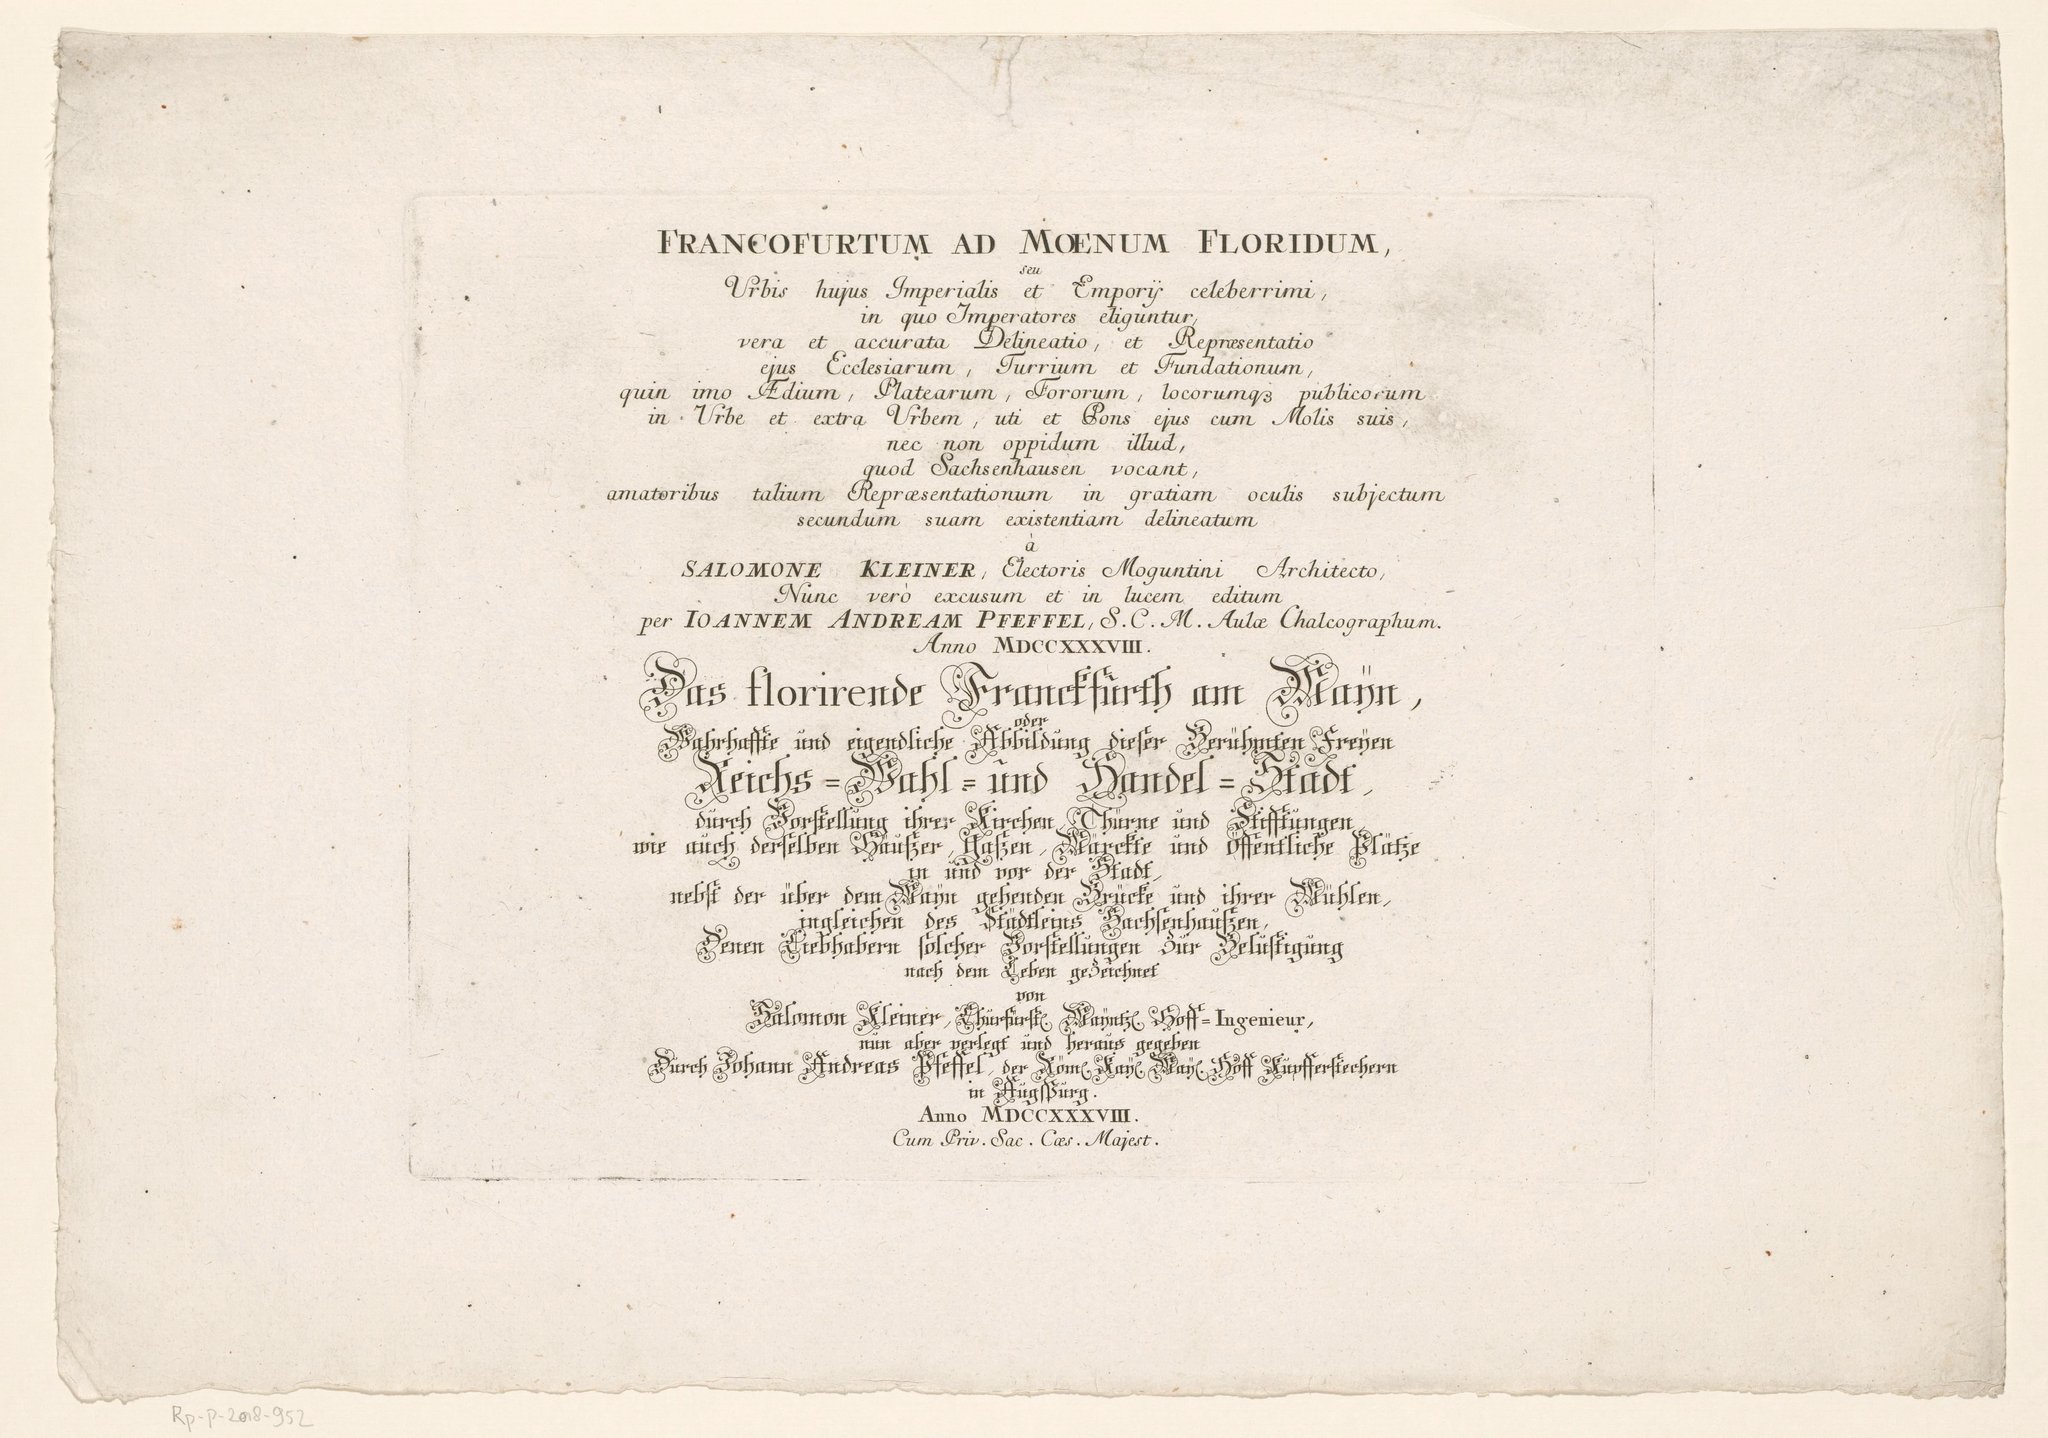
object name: titelblad, titelpagina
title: Francofurtum ad Moenum Floridum, urbis hujus imperialis (...)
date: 1738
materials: paper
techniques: engraving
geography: augsburg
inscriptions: date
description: Titelpagina voor: Francofurtum ad Moenum Floridum (...). Augsburg: Johann Andreas Pfeffel, 1738.